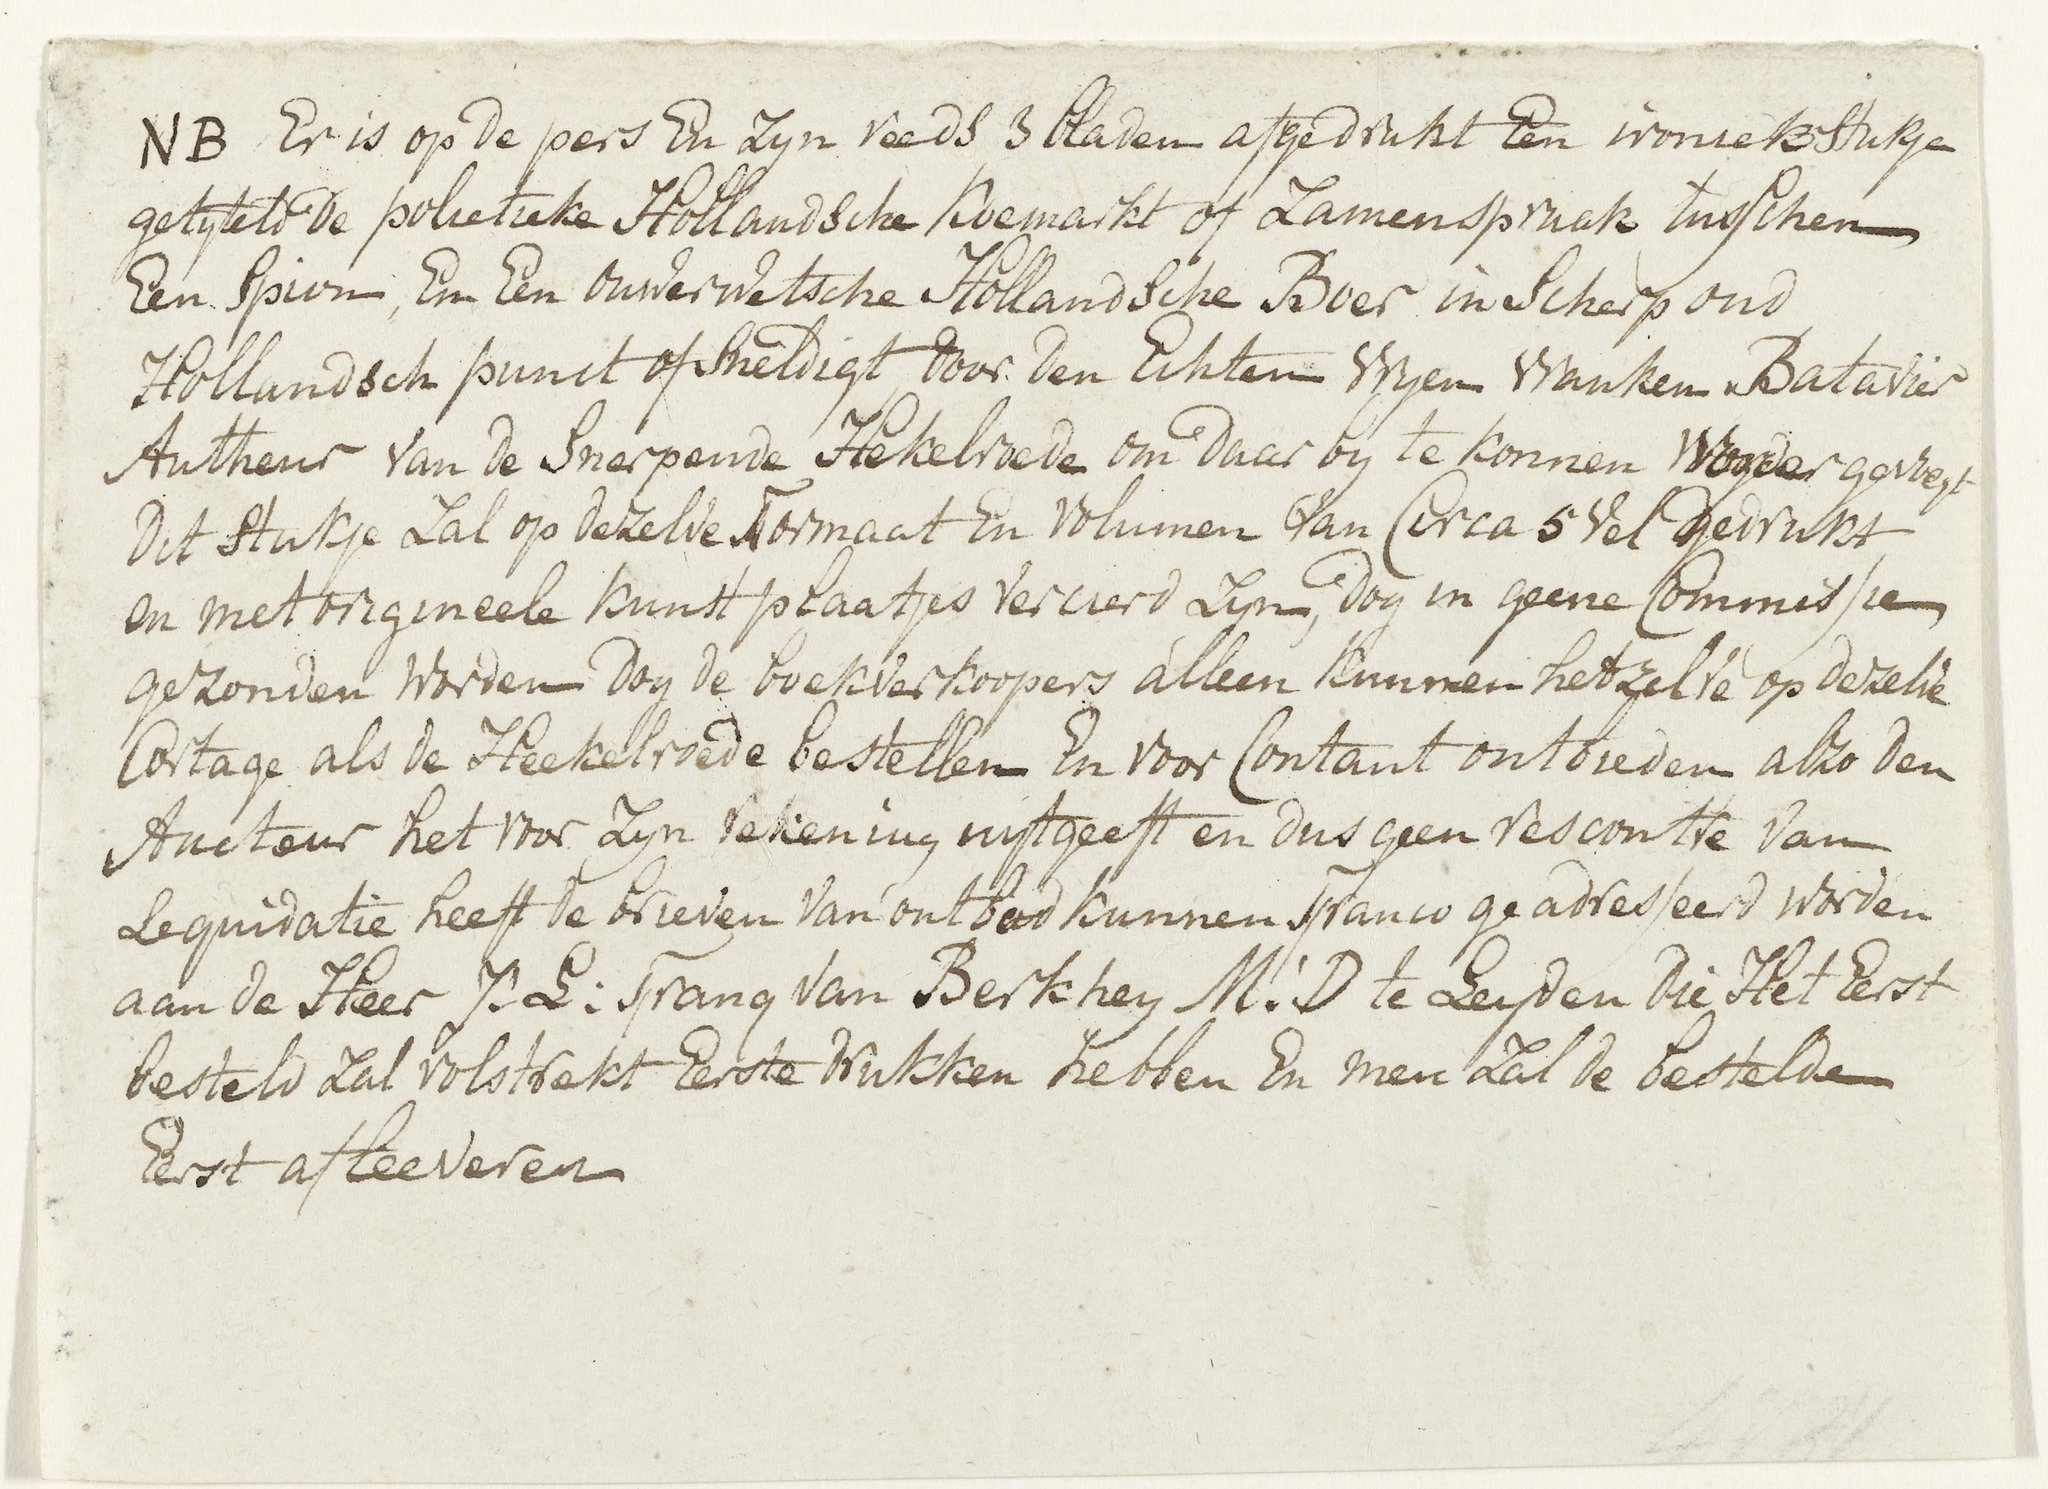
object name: manuscript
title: Advertentietekst voor: Johannes le Francq van Berkhey, De Politieke Hollandsche Koemarkt, 1787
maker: johannes le francq van berkhey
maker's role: draughtsman, print maker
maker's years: 1729-1812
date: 1787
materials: paper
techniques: writing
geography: leiden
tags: leiden, print maker, draughtsman, johannes le francq van berkhey, patriots (1780-1795)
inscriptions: inscription: ‘Jasper van Hoeken’, collector's mark: Lugt 2228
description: Handschrift met de tekst voor de advertentie in de Brielse Couranten van de uitgave van: Johannes le Francq van Berkhey, De Politieke Hollandsche Koemarkt, 1787.